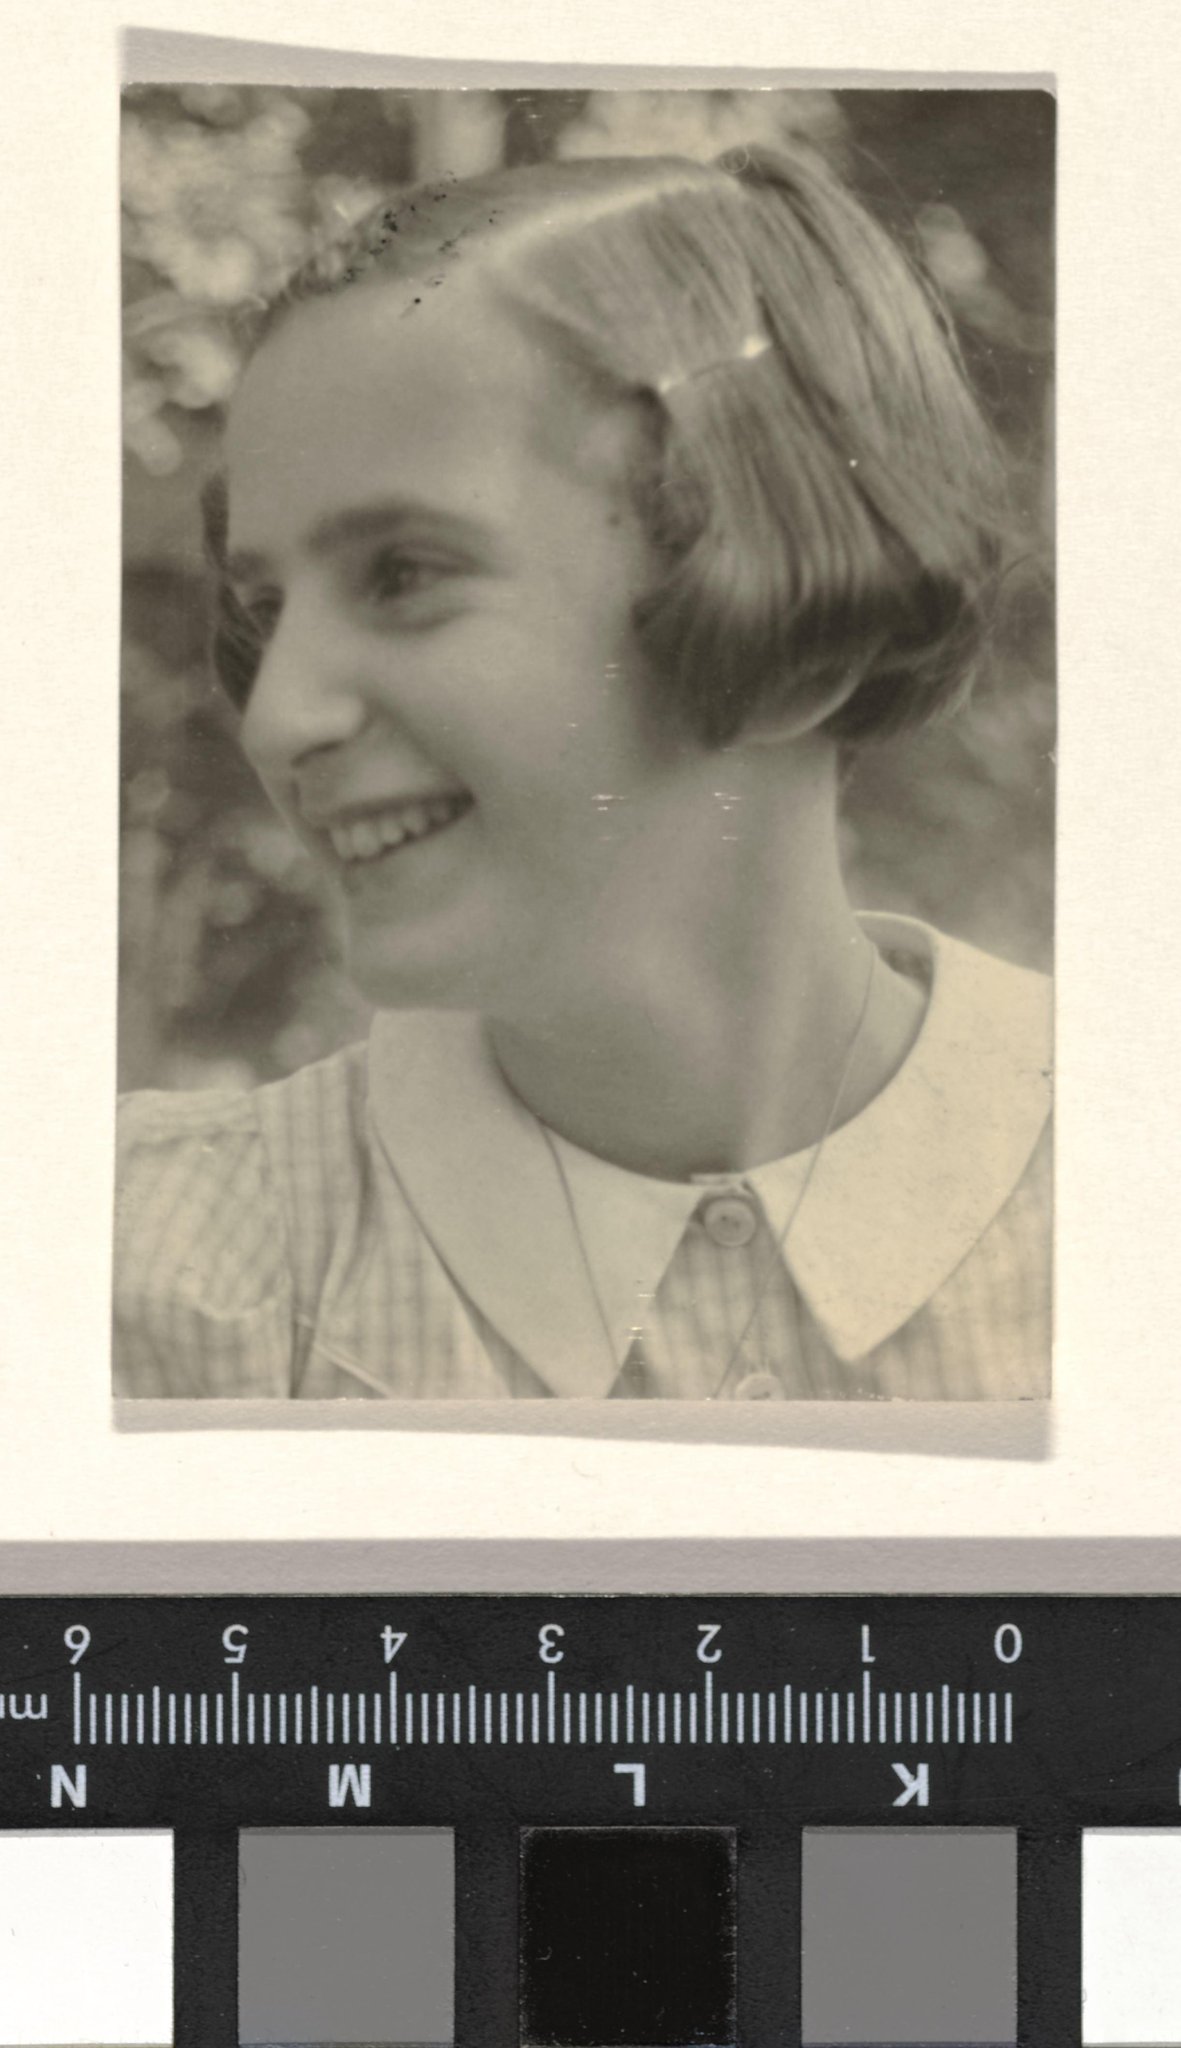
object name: photograph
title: Portret van Isabel Wachenheimer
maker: Anonymous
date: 1934-1943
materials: photographic support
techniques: gelatin silver print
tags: leiden, isabel wachenheimer-elon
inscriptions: name: ‘Isabel Wachenheimer’